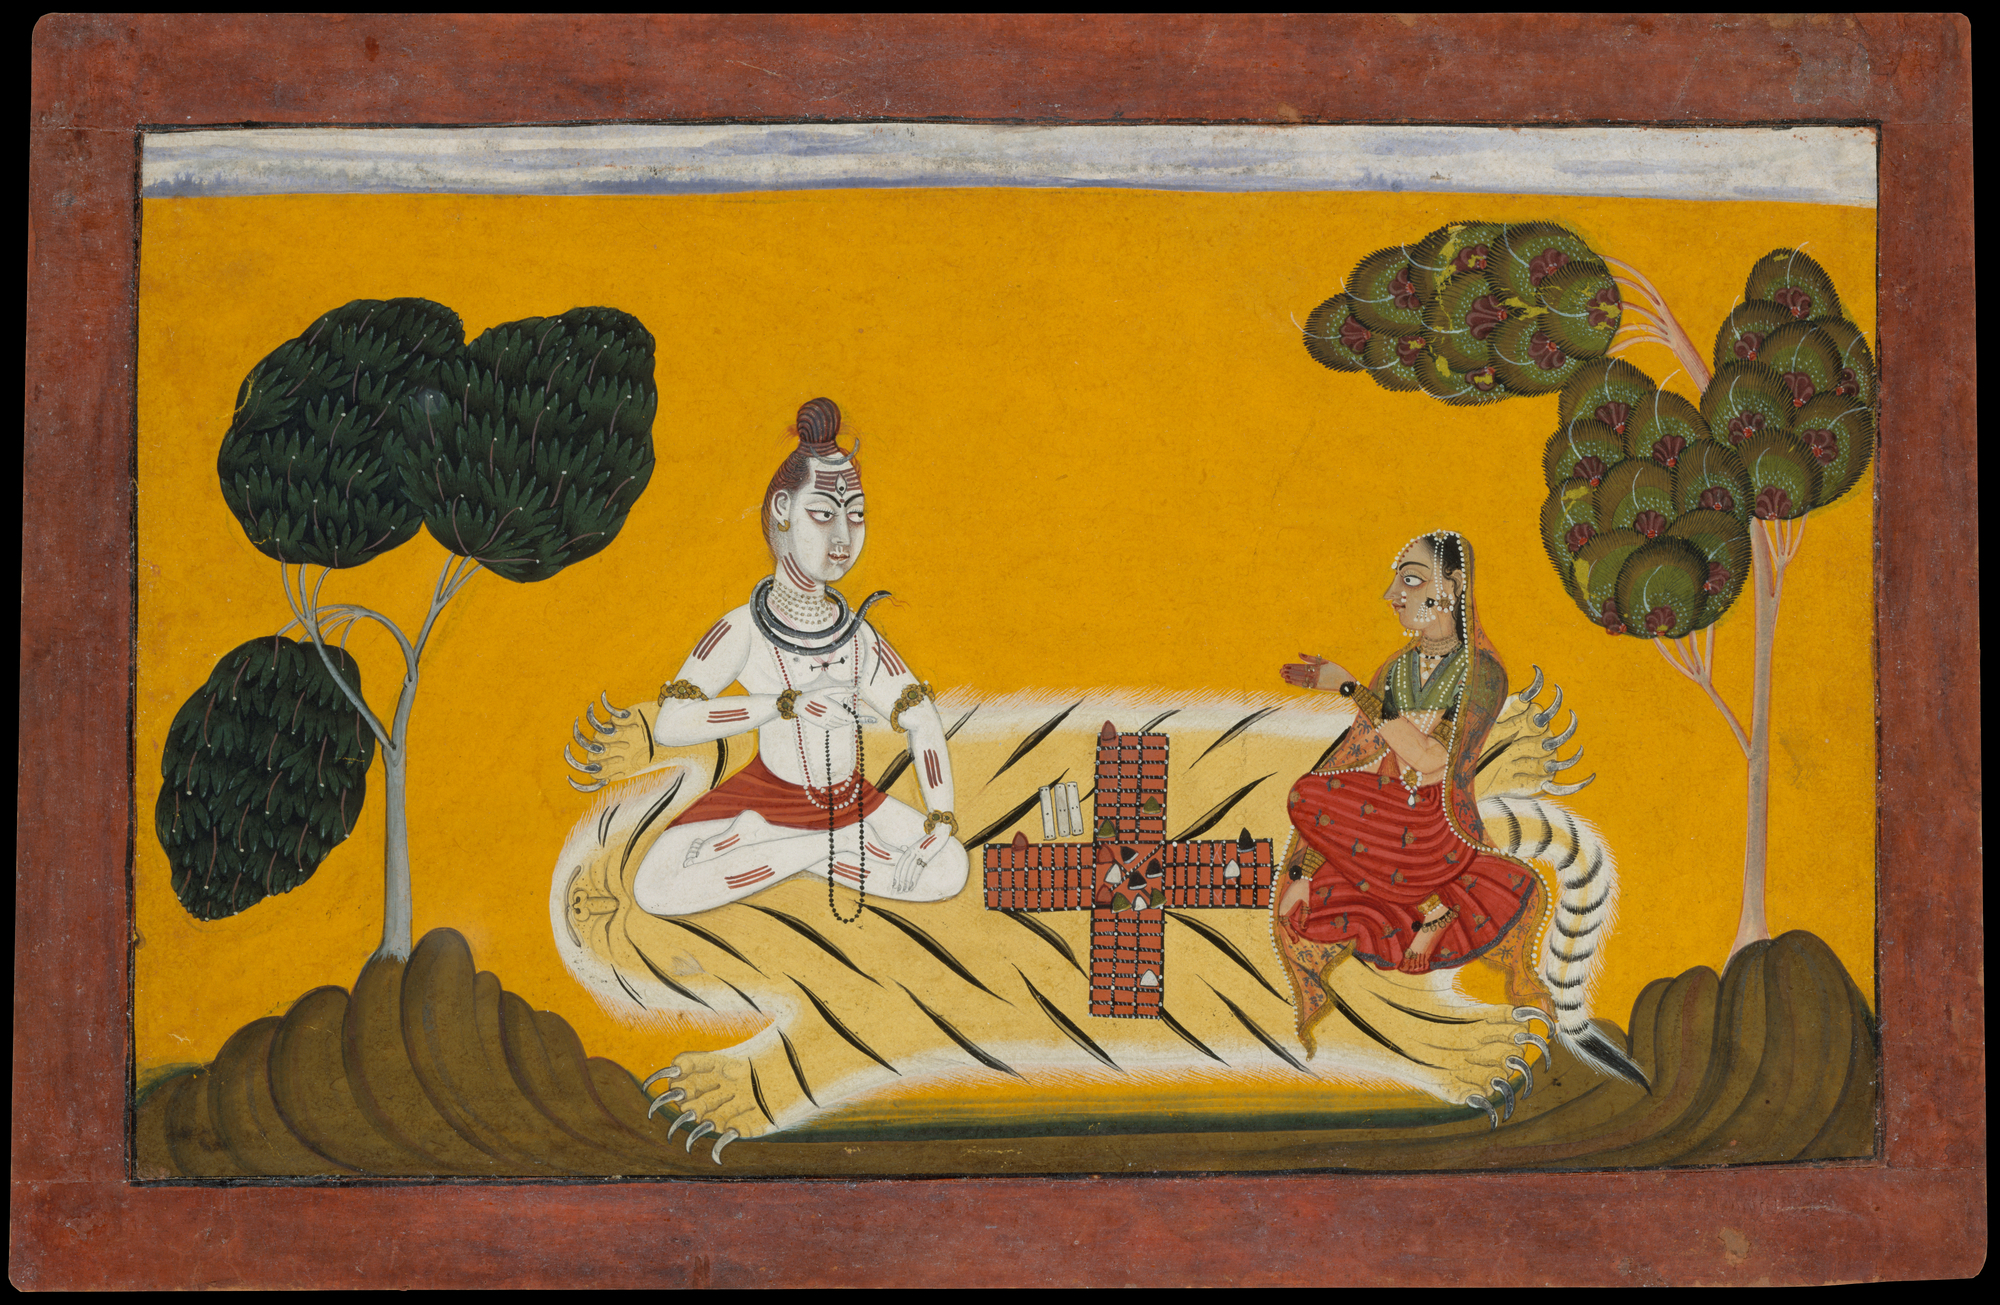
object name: folio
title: Shiva and Parvati Playing Chaupar: Folio from a Rasamanjari Series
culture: indian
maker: devidasa of nurpur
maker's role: artist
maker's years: 1670-1730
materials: gold, ink, paper, silver, watercolor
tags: parvati,shiva,games